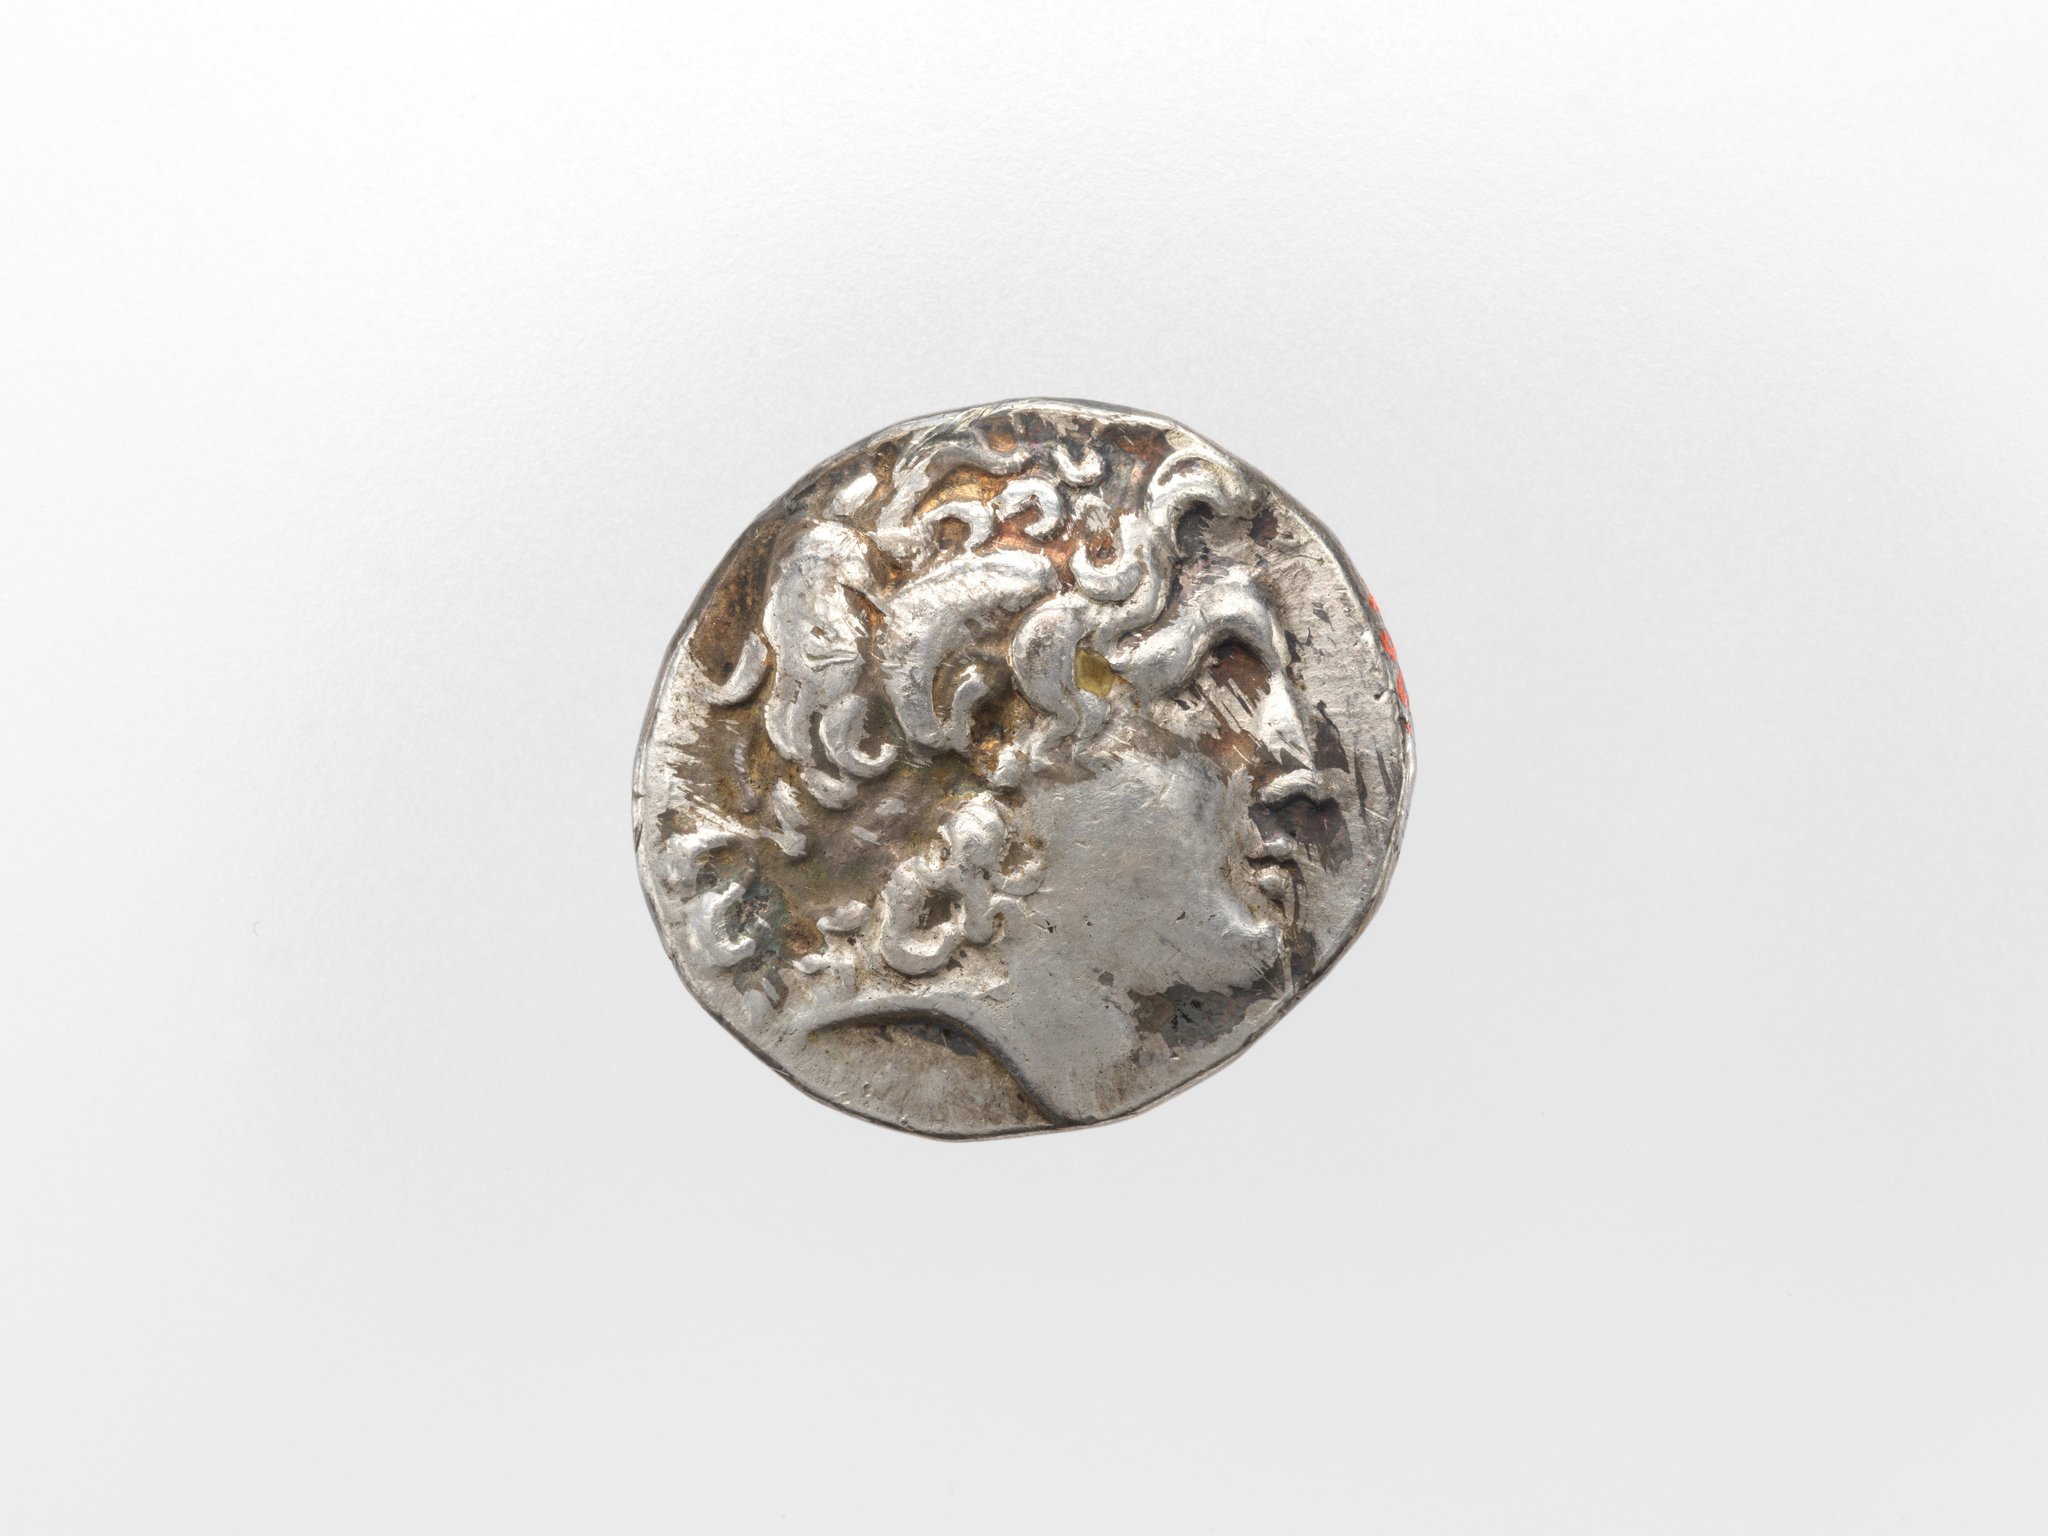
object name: tetradrachm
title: Silver tetradrachm of Lysimachos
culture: greek, macedonian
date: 297-281 BCE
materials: silver